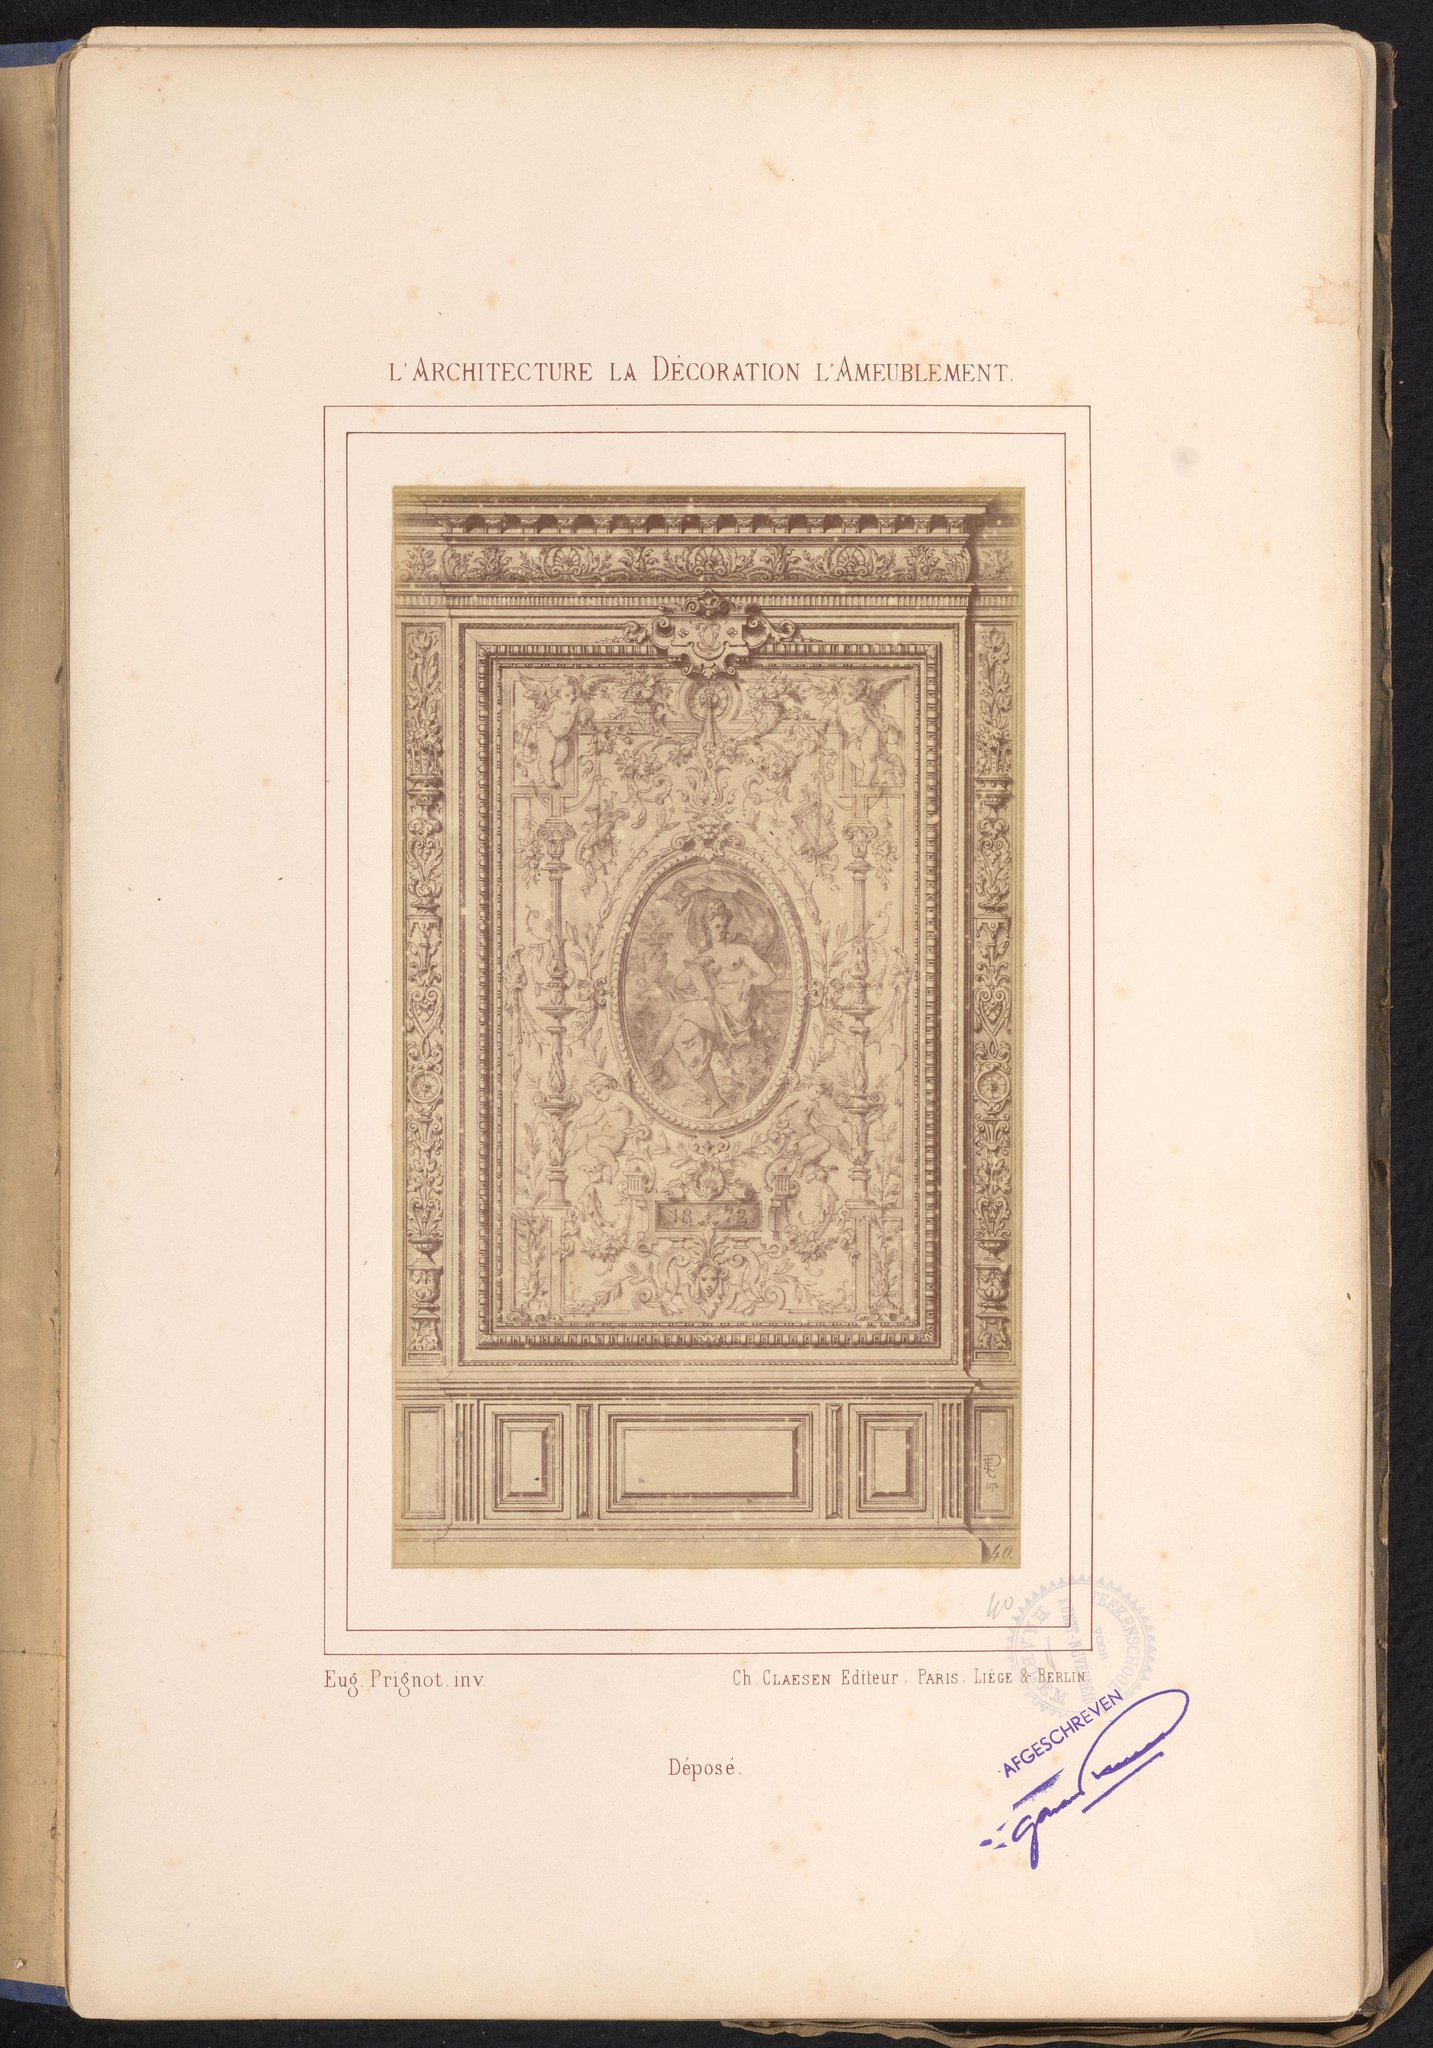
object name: reproduction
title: Fotoreproductie van een ontwerp voor een wanddecoratie met grotesken naar Alexandre Eugène Prignot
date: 1873-1880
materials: cardboard, paper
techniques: albumen print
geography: liège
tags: ornament ~ grotesque, wall-covering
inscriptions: stamp: ‘AFGESCHREVEN/ [...]’, number: ‘40’, inscription: ‘Eug. Prignot. inv.’, stamp: ‘TEEKENSCHOOL/ VOOR/ KUNST-NIJVERHEID/ HAARLEM’, inscription: ‘Déposé’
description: Deze foto maakt deel uit van een omslag met 61 foto's op 61 bladen.